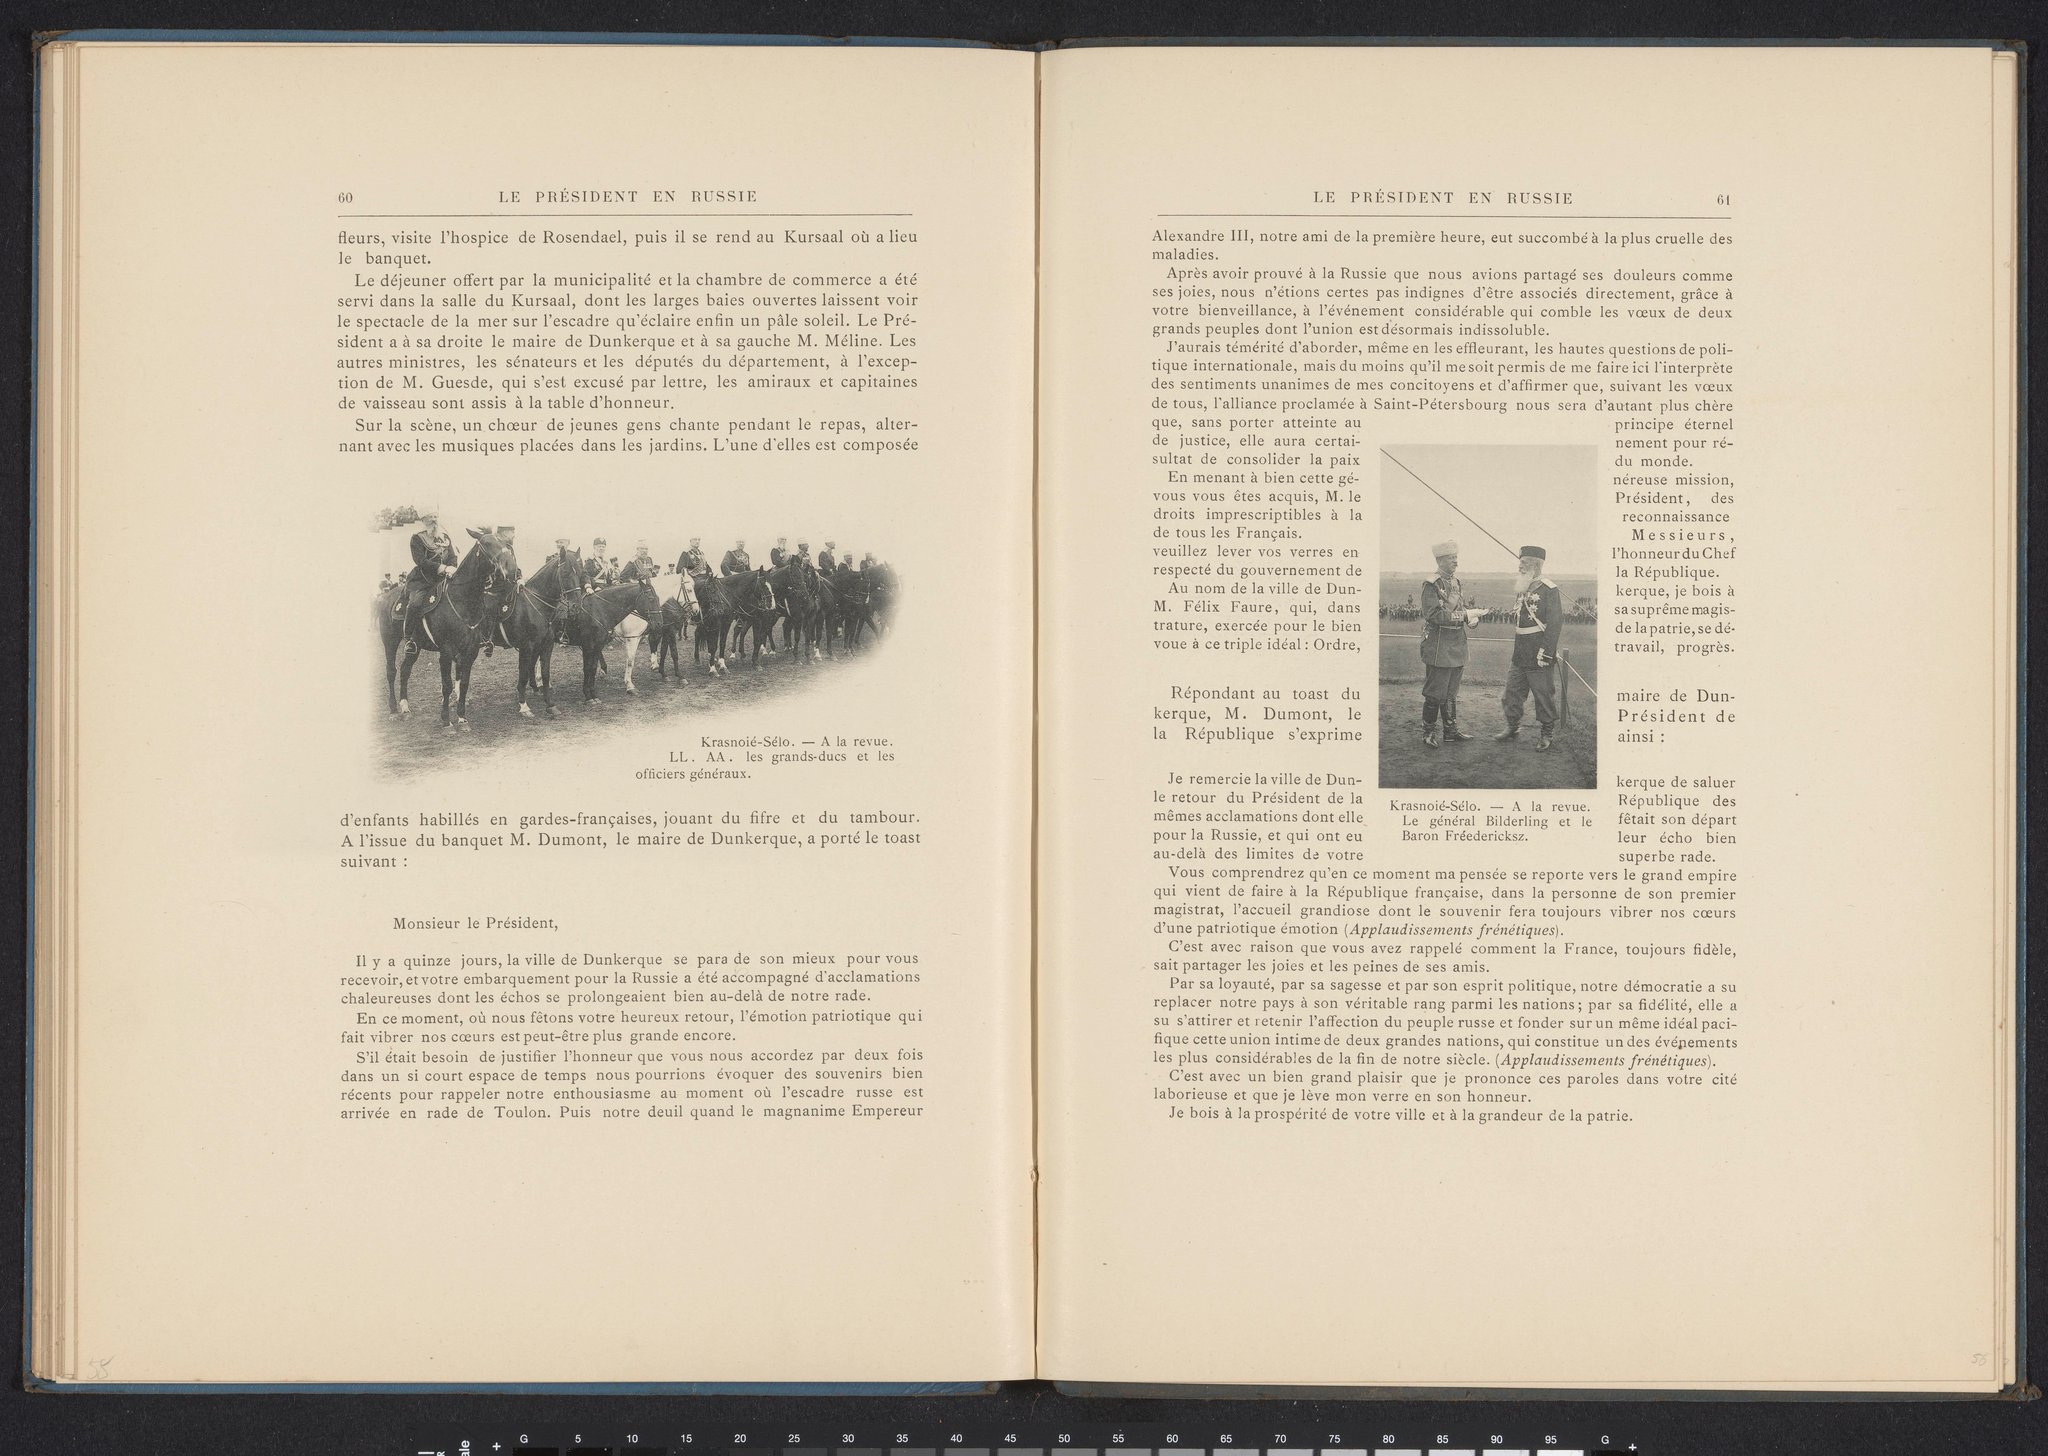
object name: page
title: Generaal Alexandr von Bilderling en baron Adolf Freedericksz te Krasoye Selo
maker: Anonymous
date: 1897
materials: paper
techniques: photograph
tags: commander-in-chief, general, marshal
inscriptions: inscription: ‘Krasnoié-Sélo-(...) Fréedericksz.’